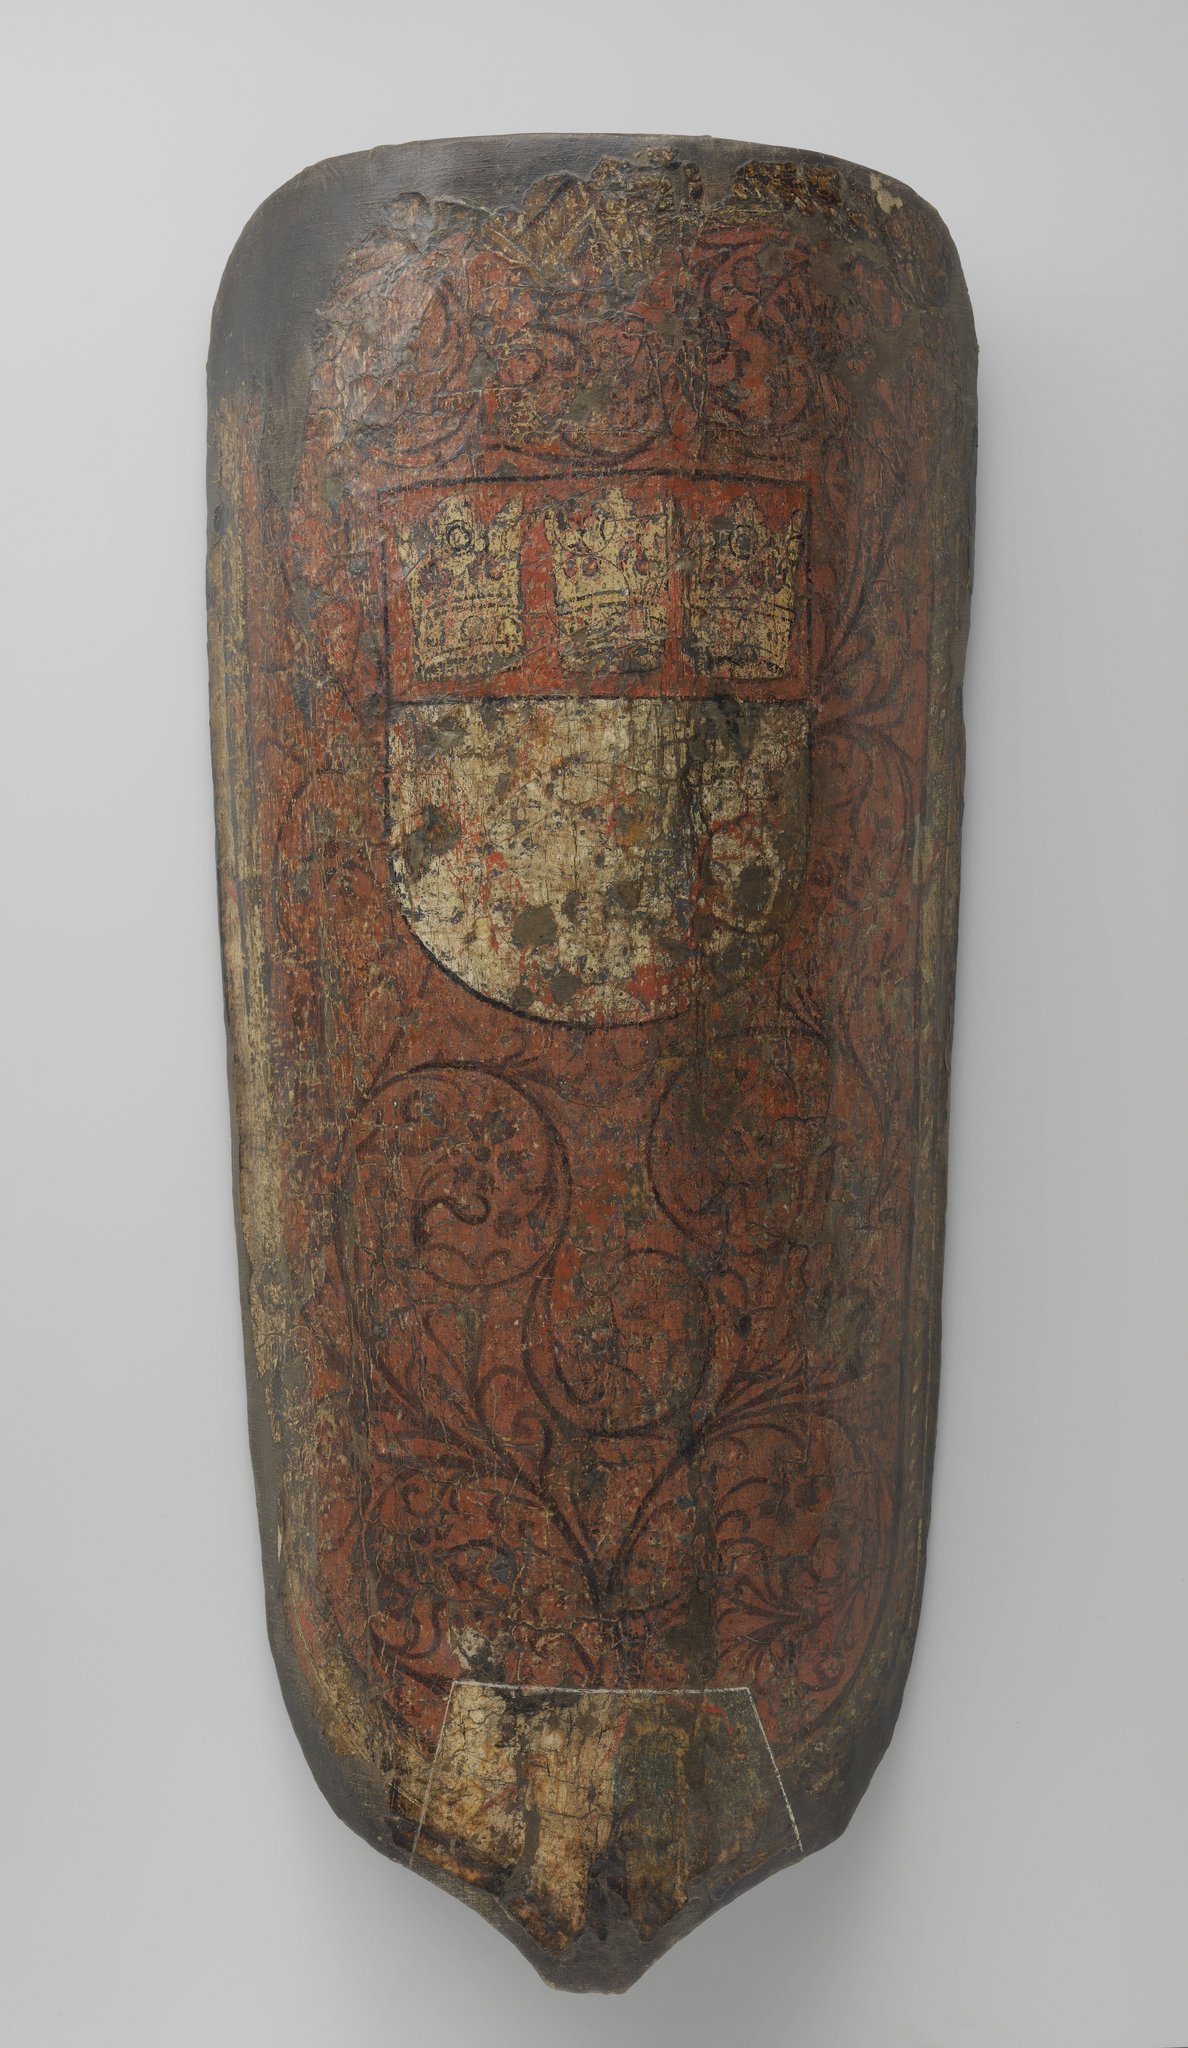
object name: shield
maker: Anonymous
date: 1474-1475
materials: oil, wood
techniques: painted, weave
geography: low countries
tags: earl, charles the bold (duke of burgundy), coat of arms (as symbol of the state, etc.) (+ city; municipal), cologne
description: A shield offered protection in battle and made its carrier recognizable on the battlefield since it bore the symbol of the ruler or town for which he was fighting. The shield with three crowns is from the German town of Cologne, and the shield with Saint Andrew’s cross is that of the Duke of Burgundy, who ruled over several Dutch provinces.